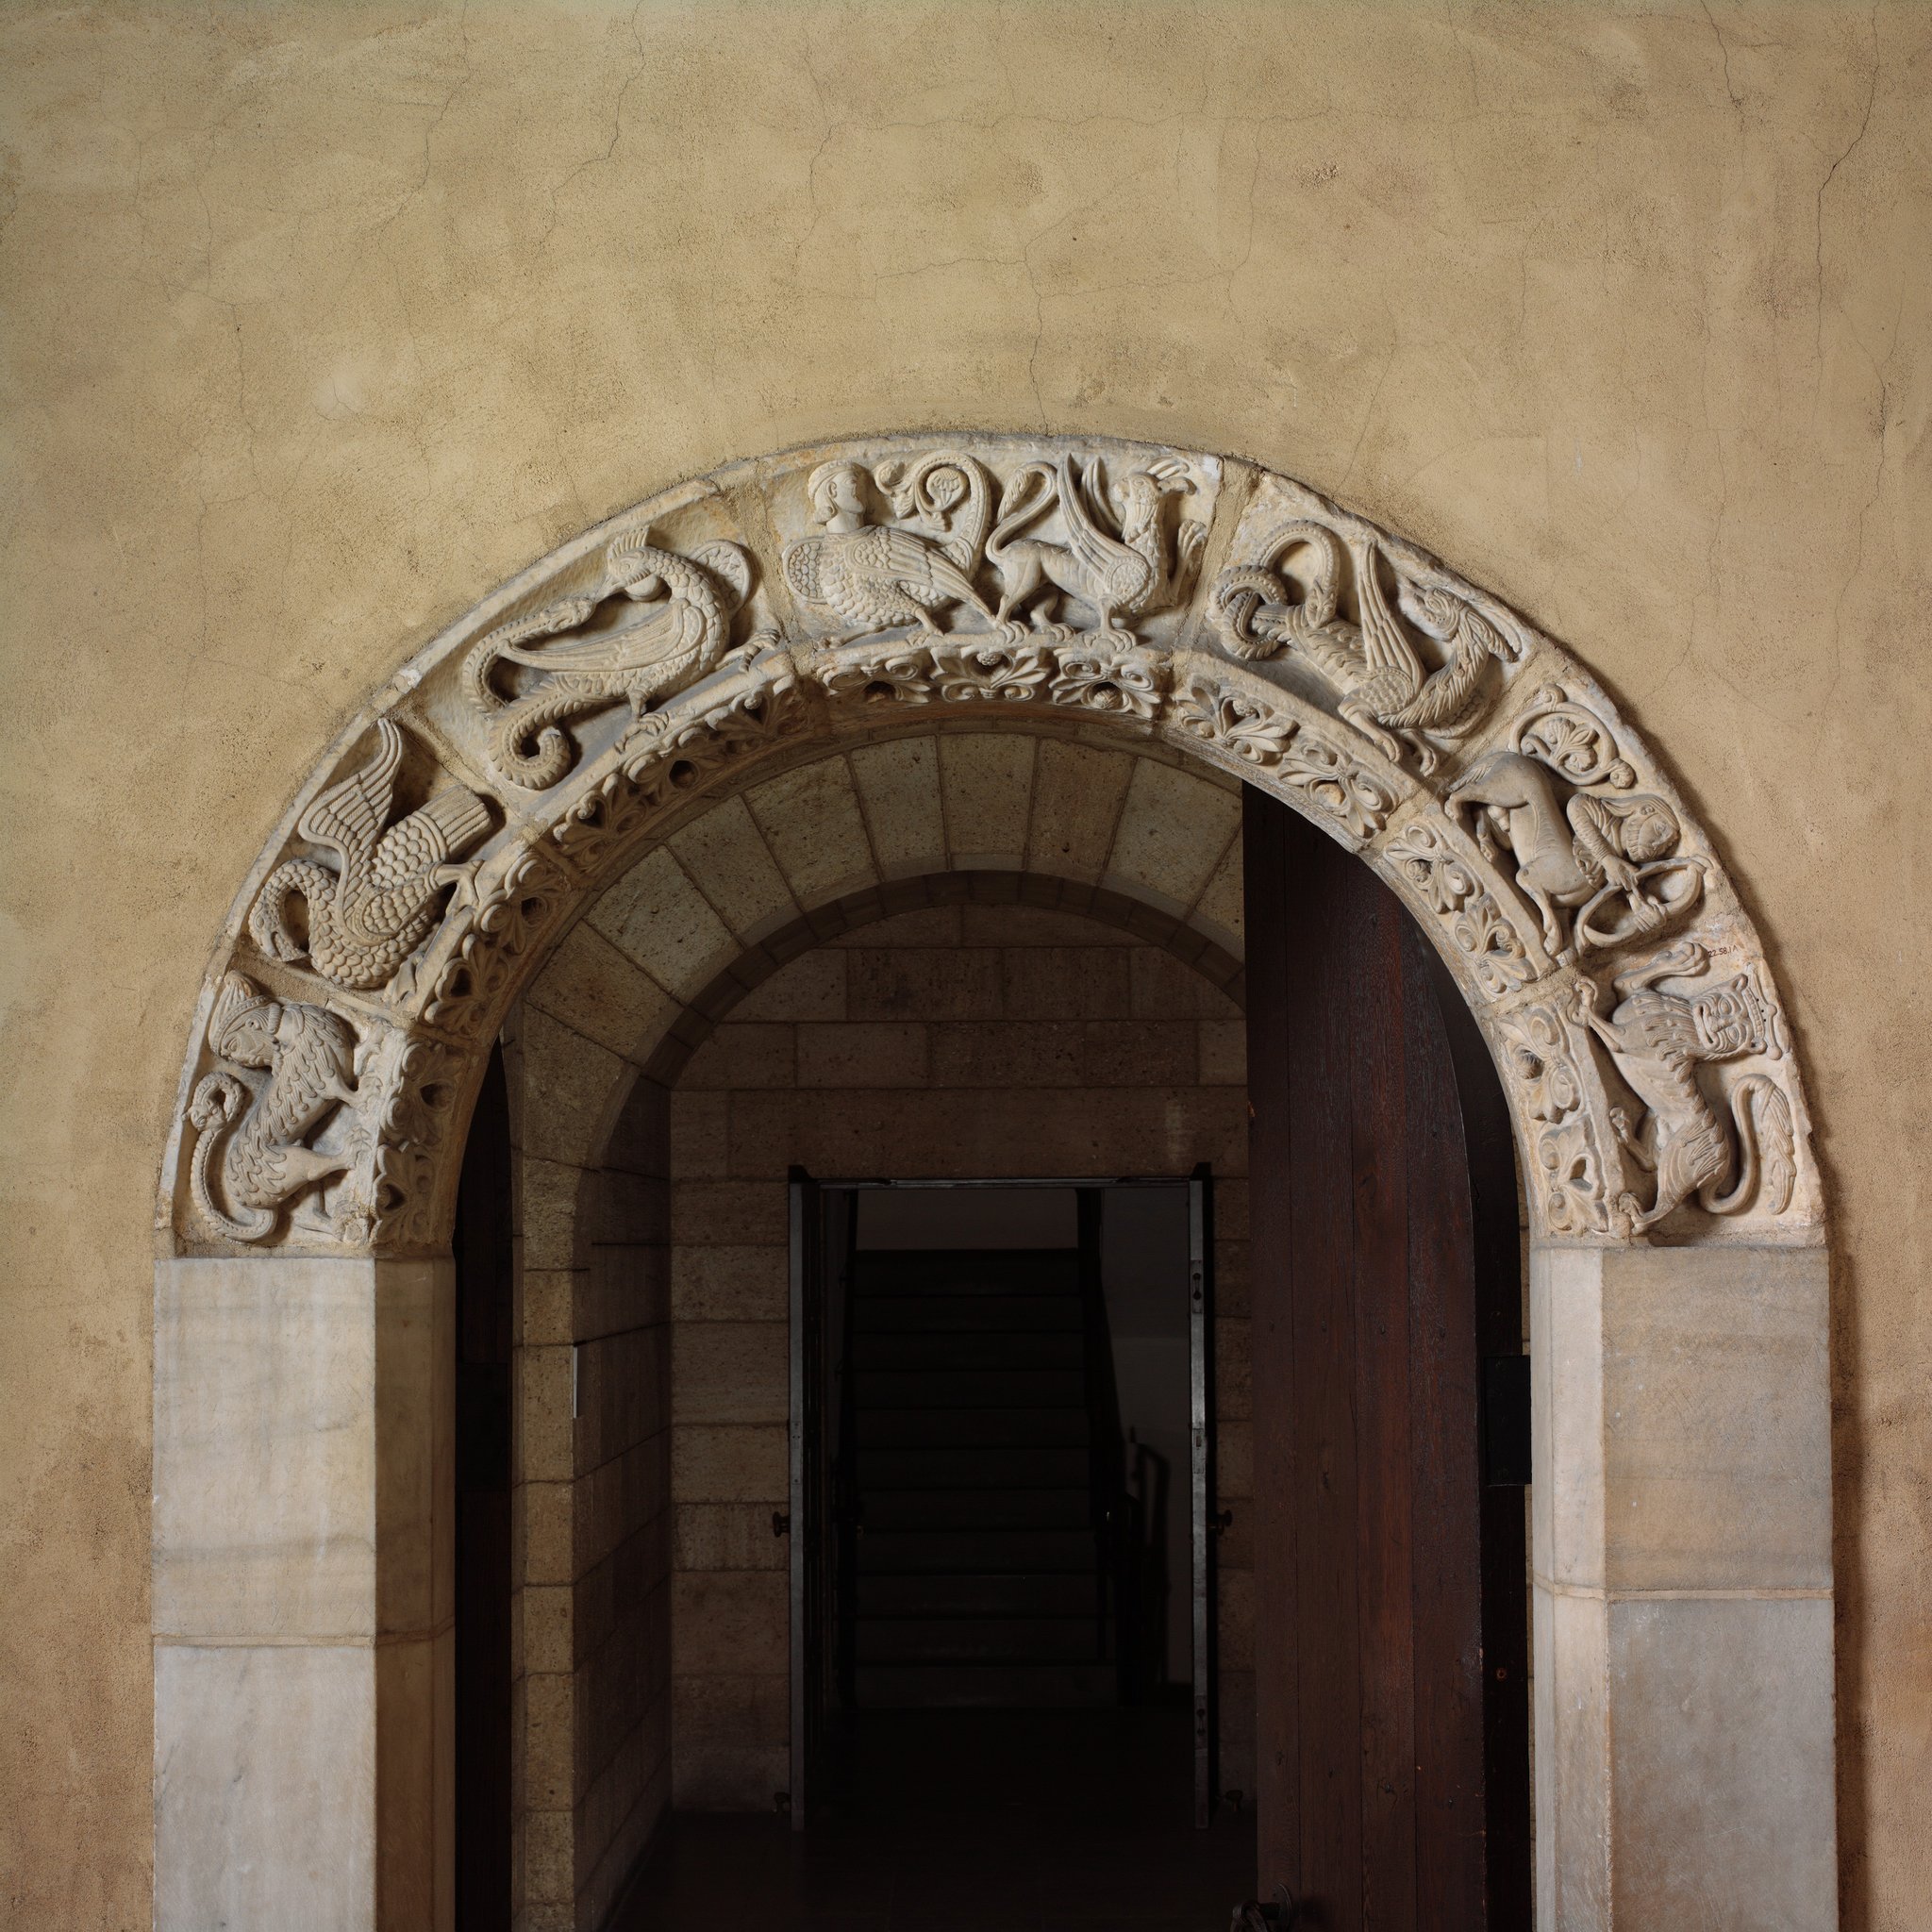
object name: arch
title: Arch with Beasts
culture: french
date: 1150-1175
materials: marble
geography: france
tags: centaurs,dragons,griffins